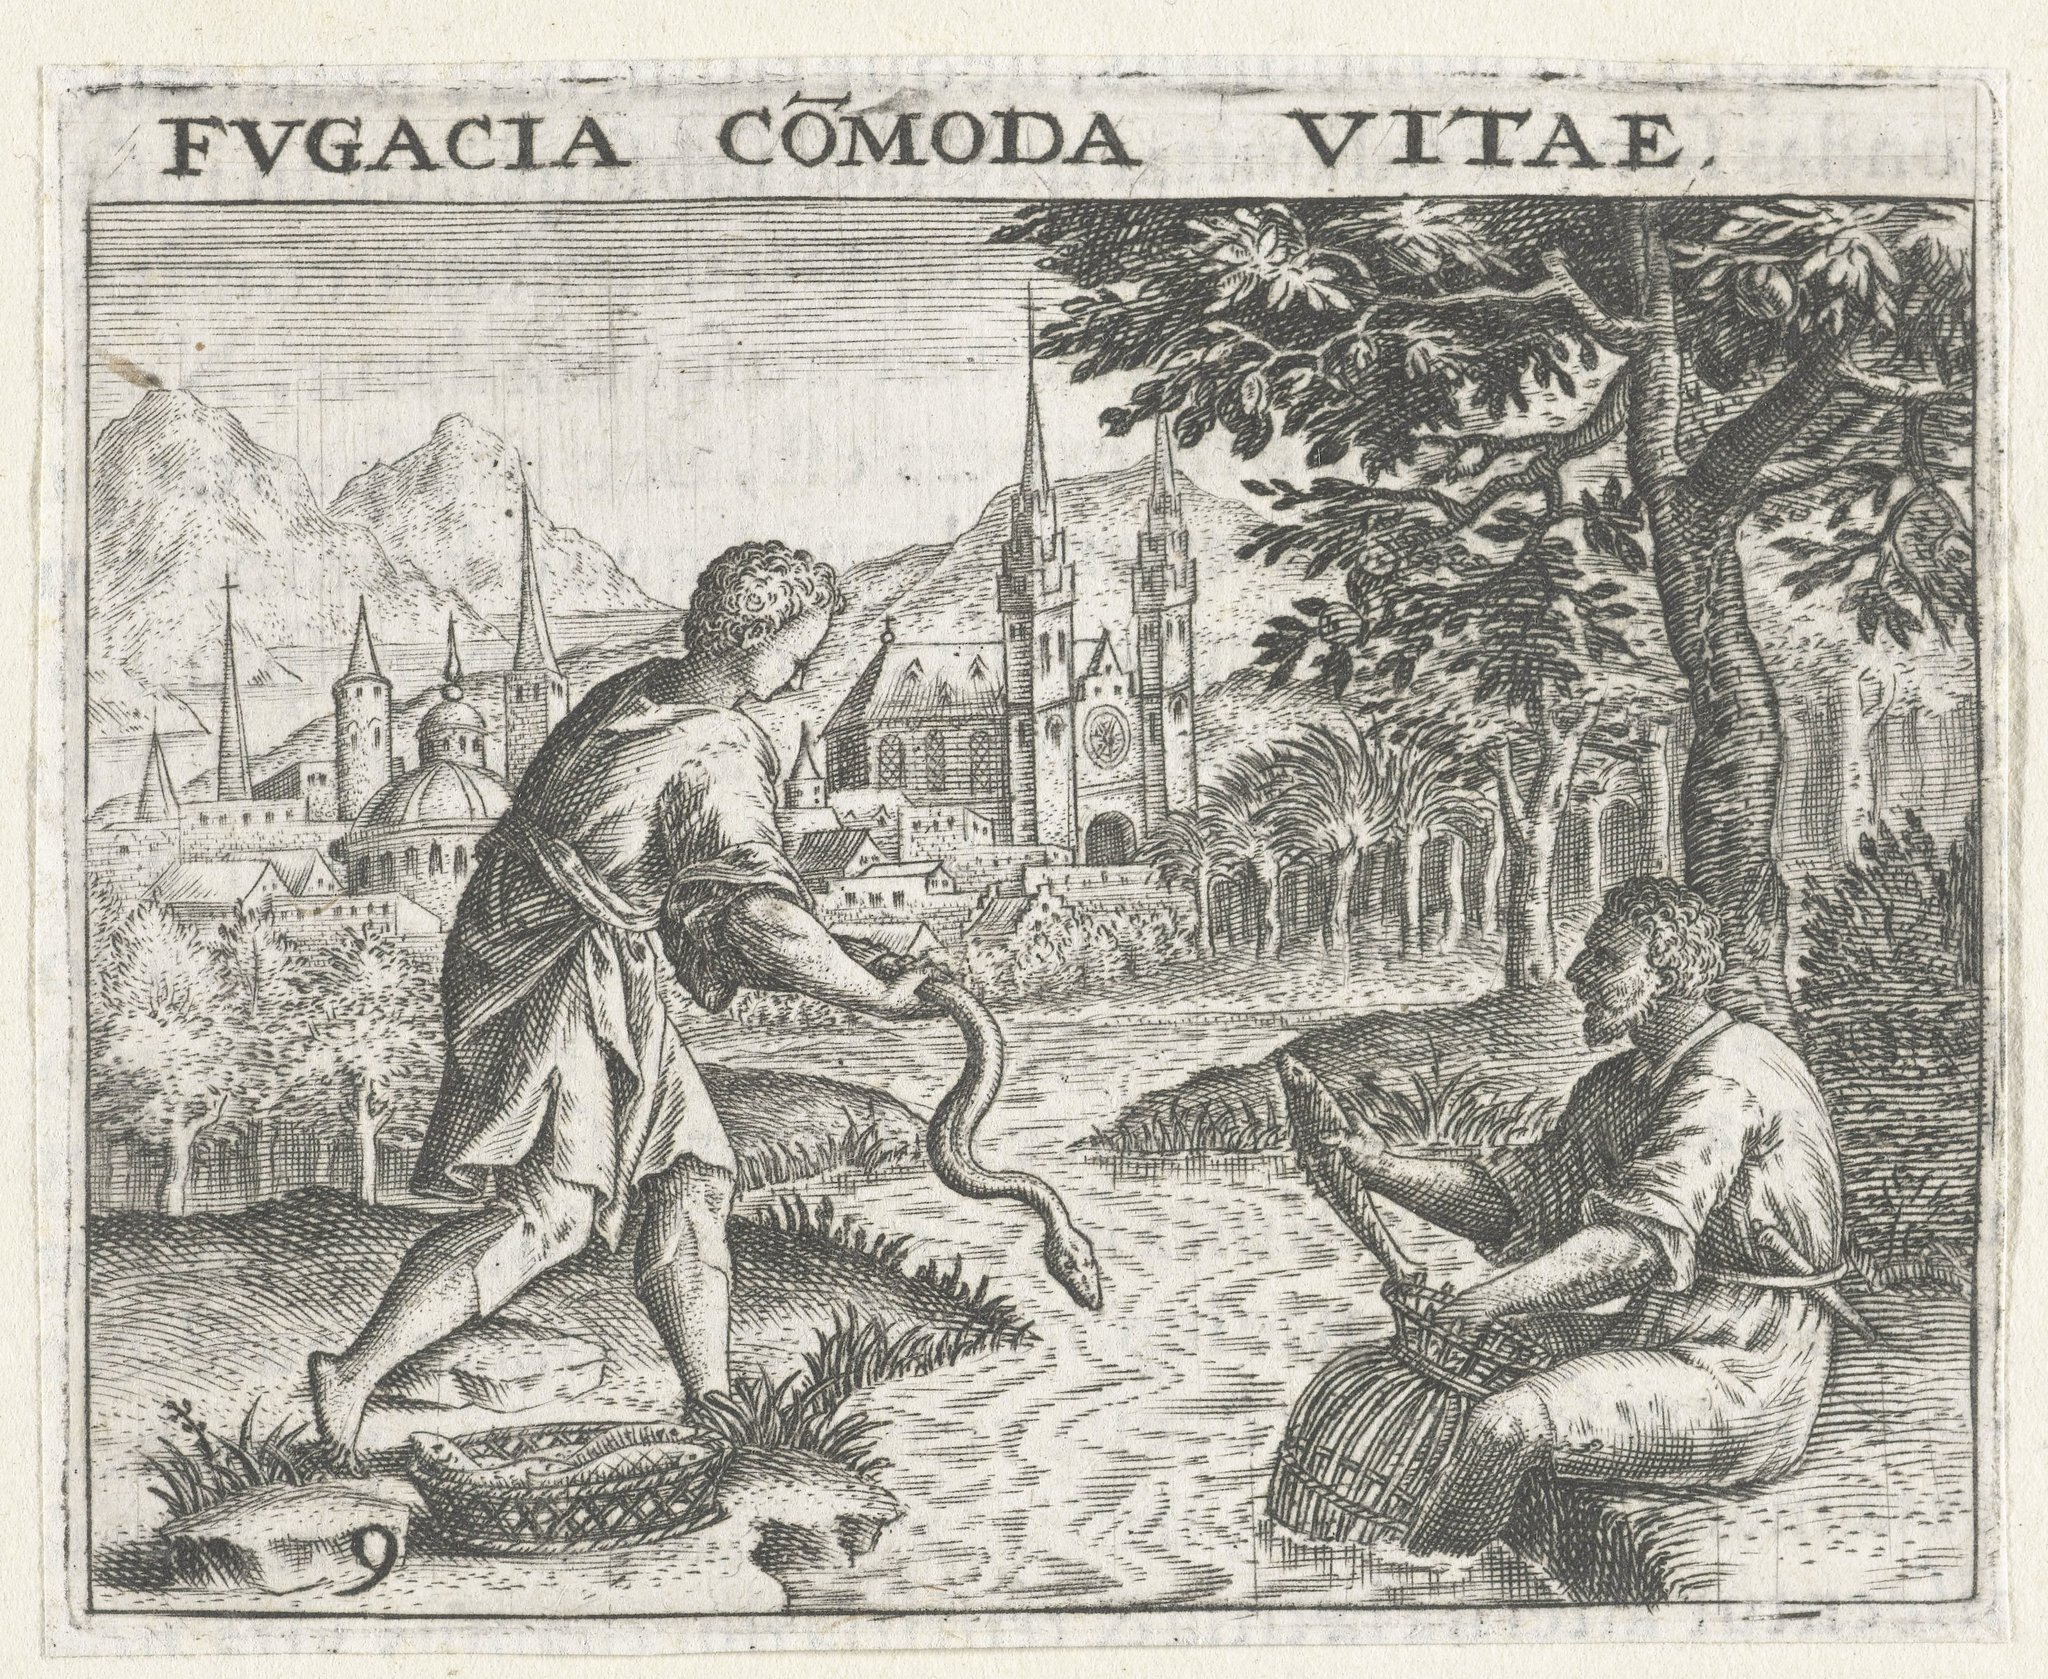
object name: book illustration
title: FUGACIA COMODA VITAE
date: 1596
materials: paper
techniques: engraving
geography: frankfurt am main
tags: snakes, fisherman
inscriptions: collector's mark: Lugt 240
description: Twee vissers zitten aan de oever van een riviertje. De rechter haalt een vis uit een fuik. De linker houdt een slang in zijn handen. Naast hem ligt een mandje met vissen. In het verschiet is een stad met een grote kathedraal te zien.